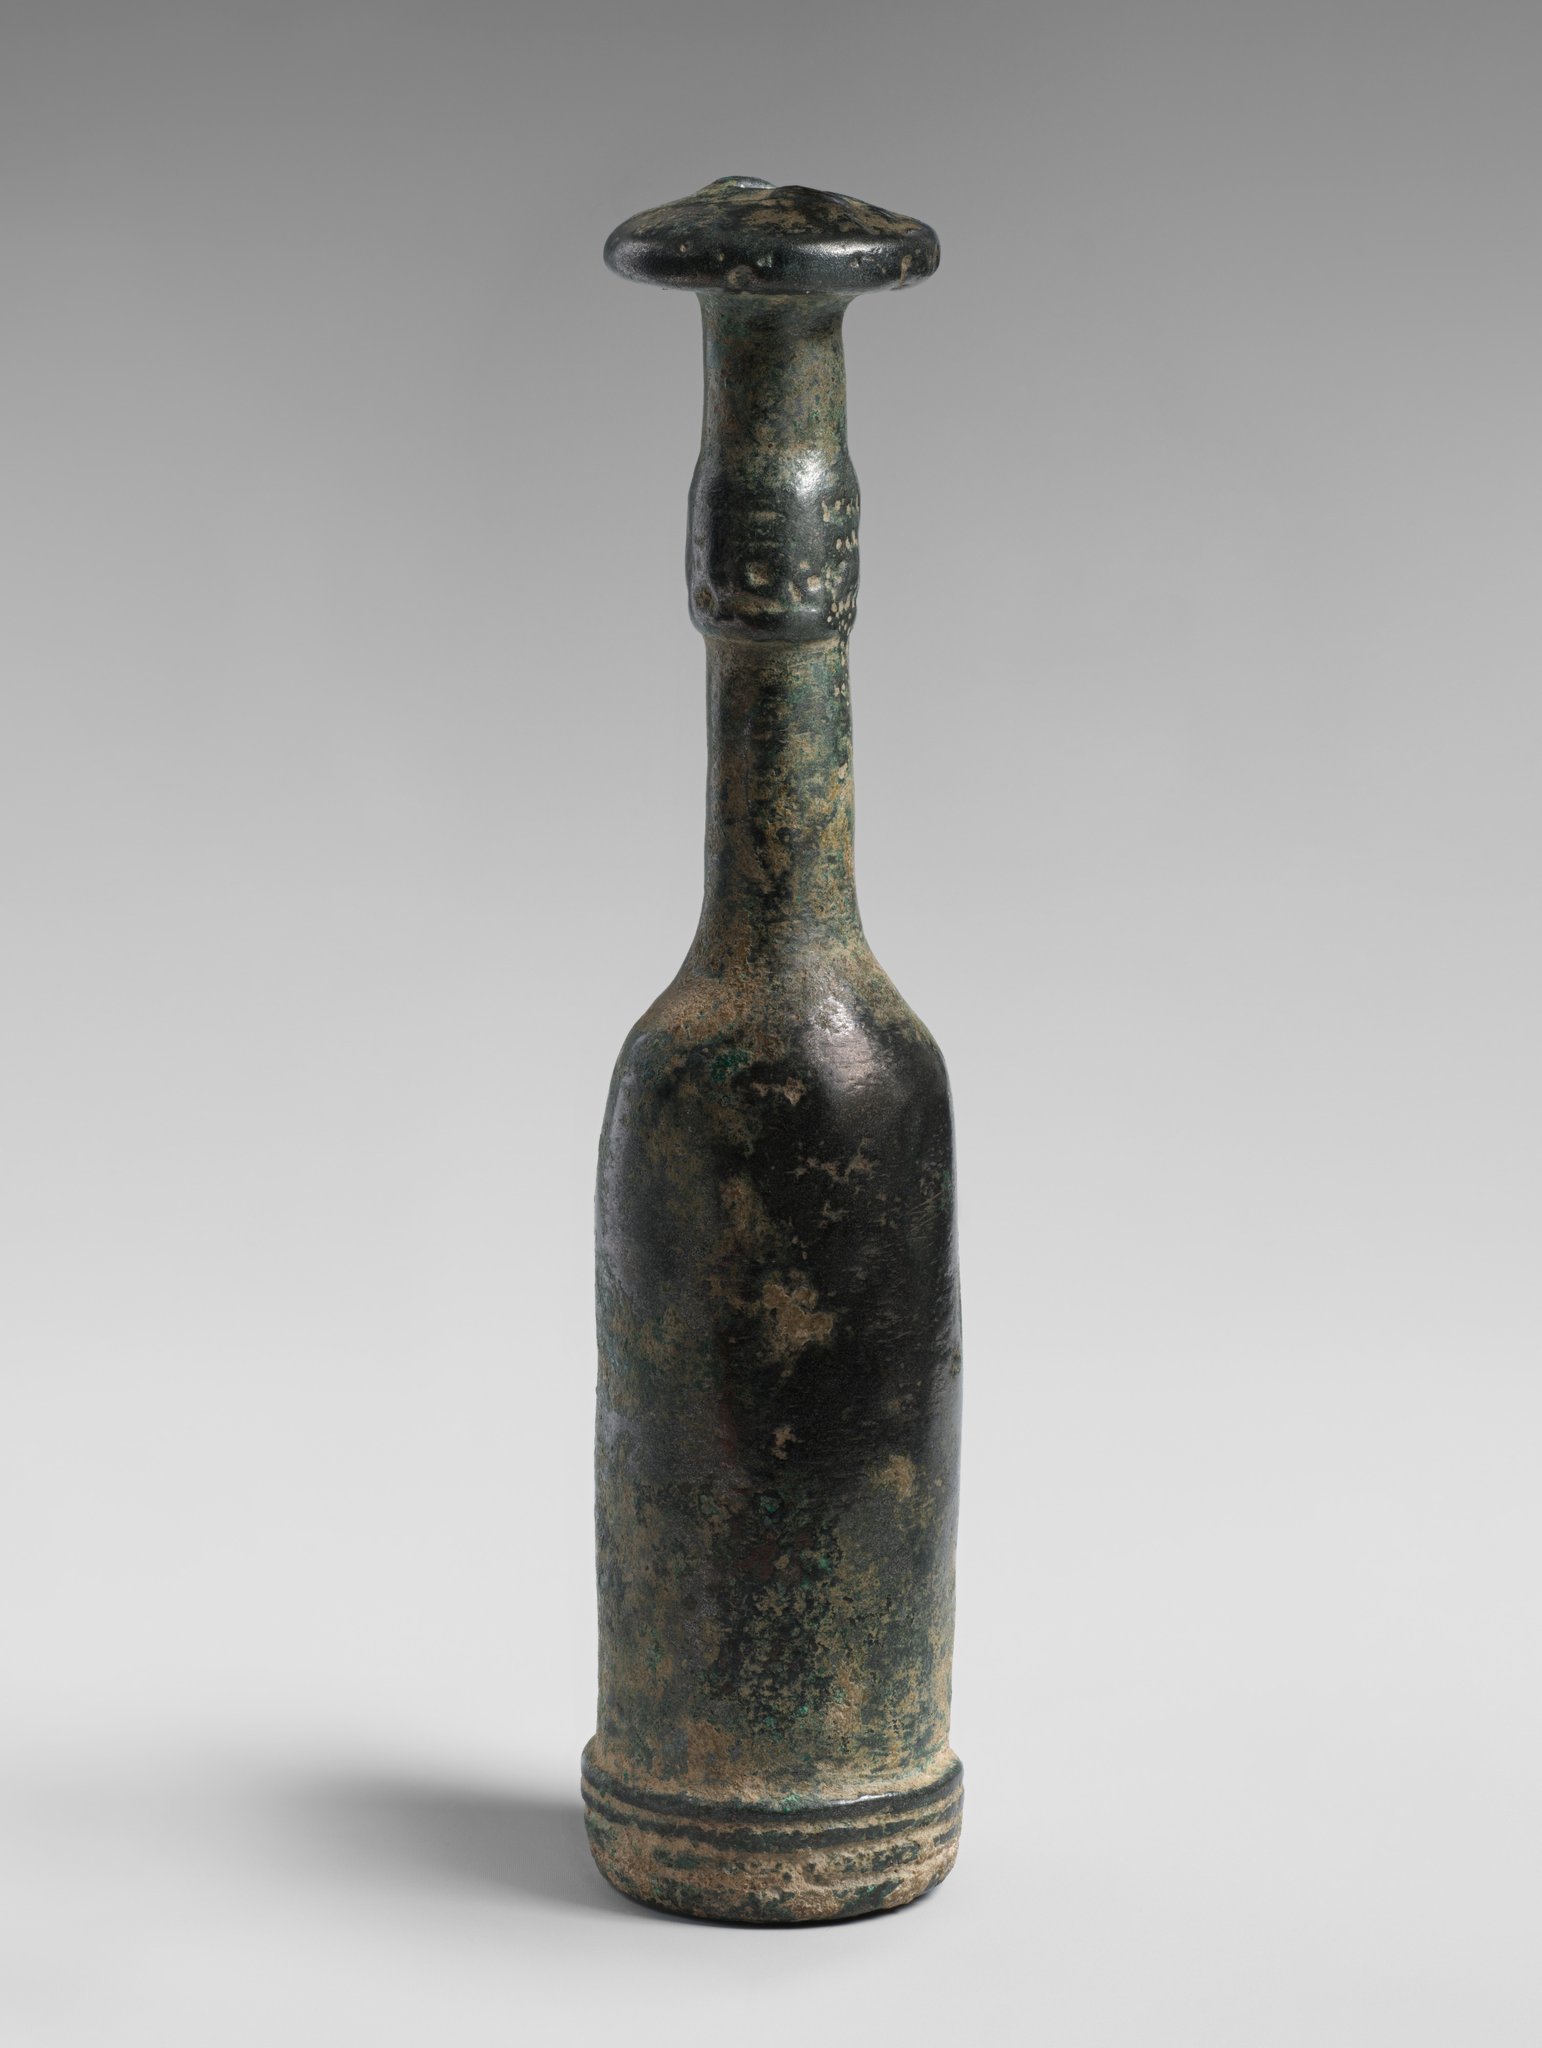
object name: standard support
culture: iranian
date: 800-601 BCE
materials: bronze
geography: iran, probably from luristan